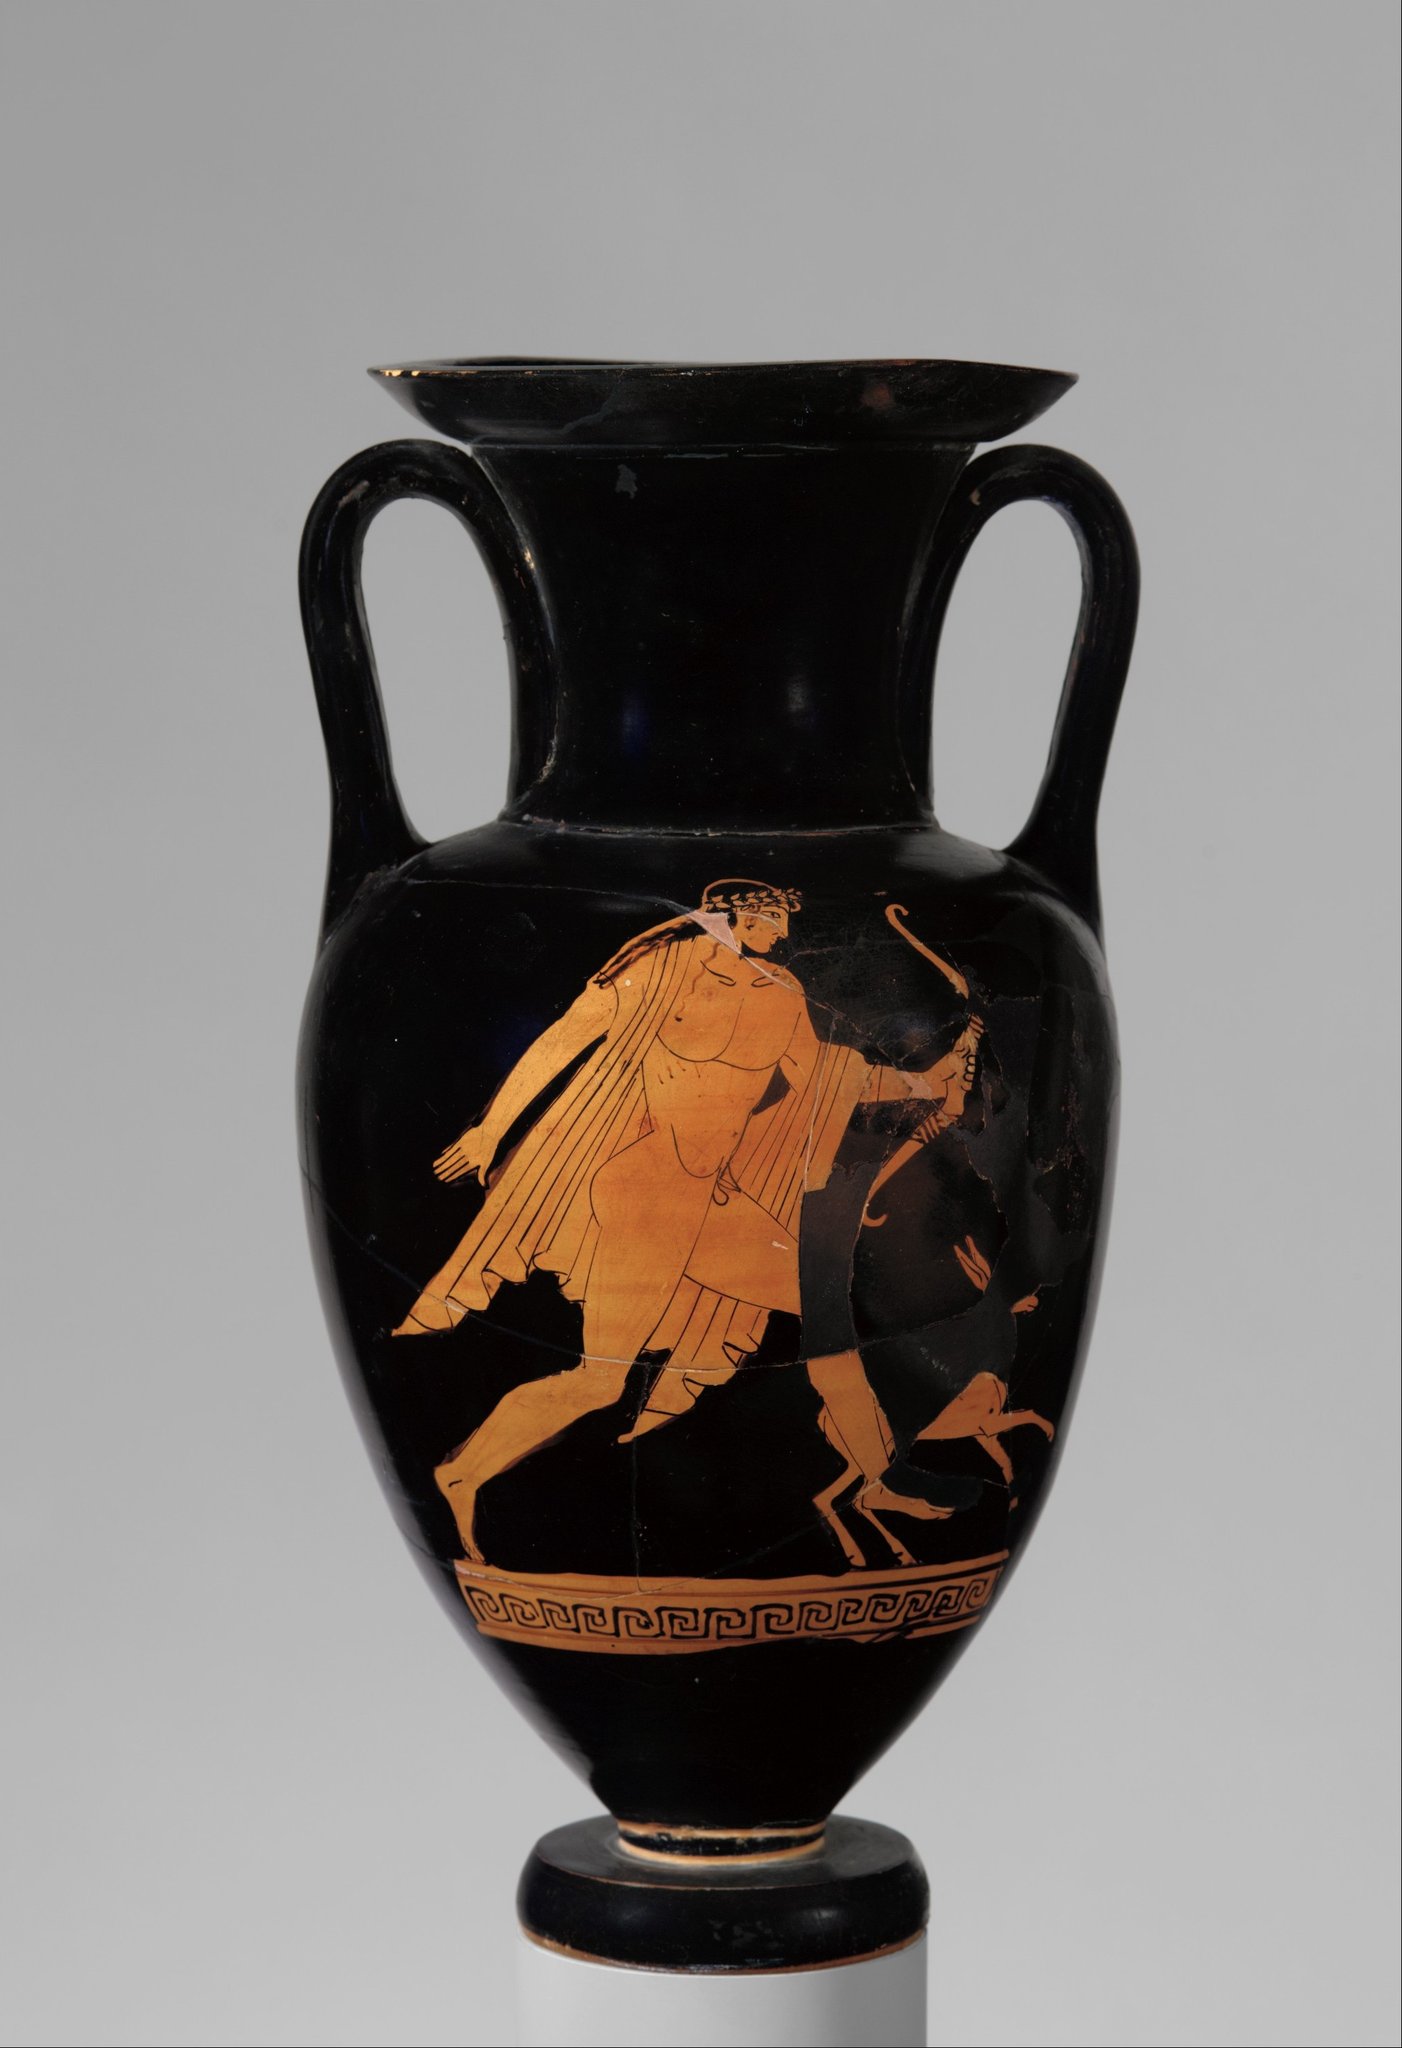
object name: nolan neck amphora with ridged handle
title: Terracotta Nolan neck-amphora (jar)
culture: greek, attic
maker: bowdoin painter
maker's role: artist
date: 480-470 BCE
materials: terracotta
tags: bow and arrow,women,apollo,deer